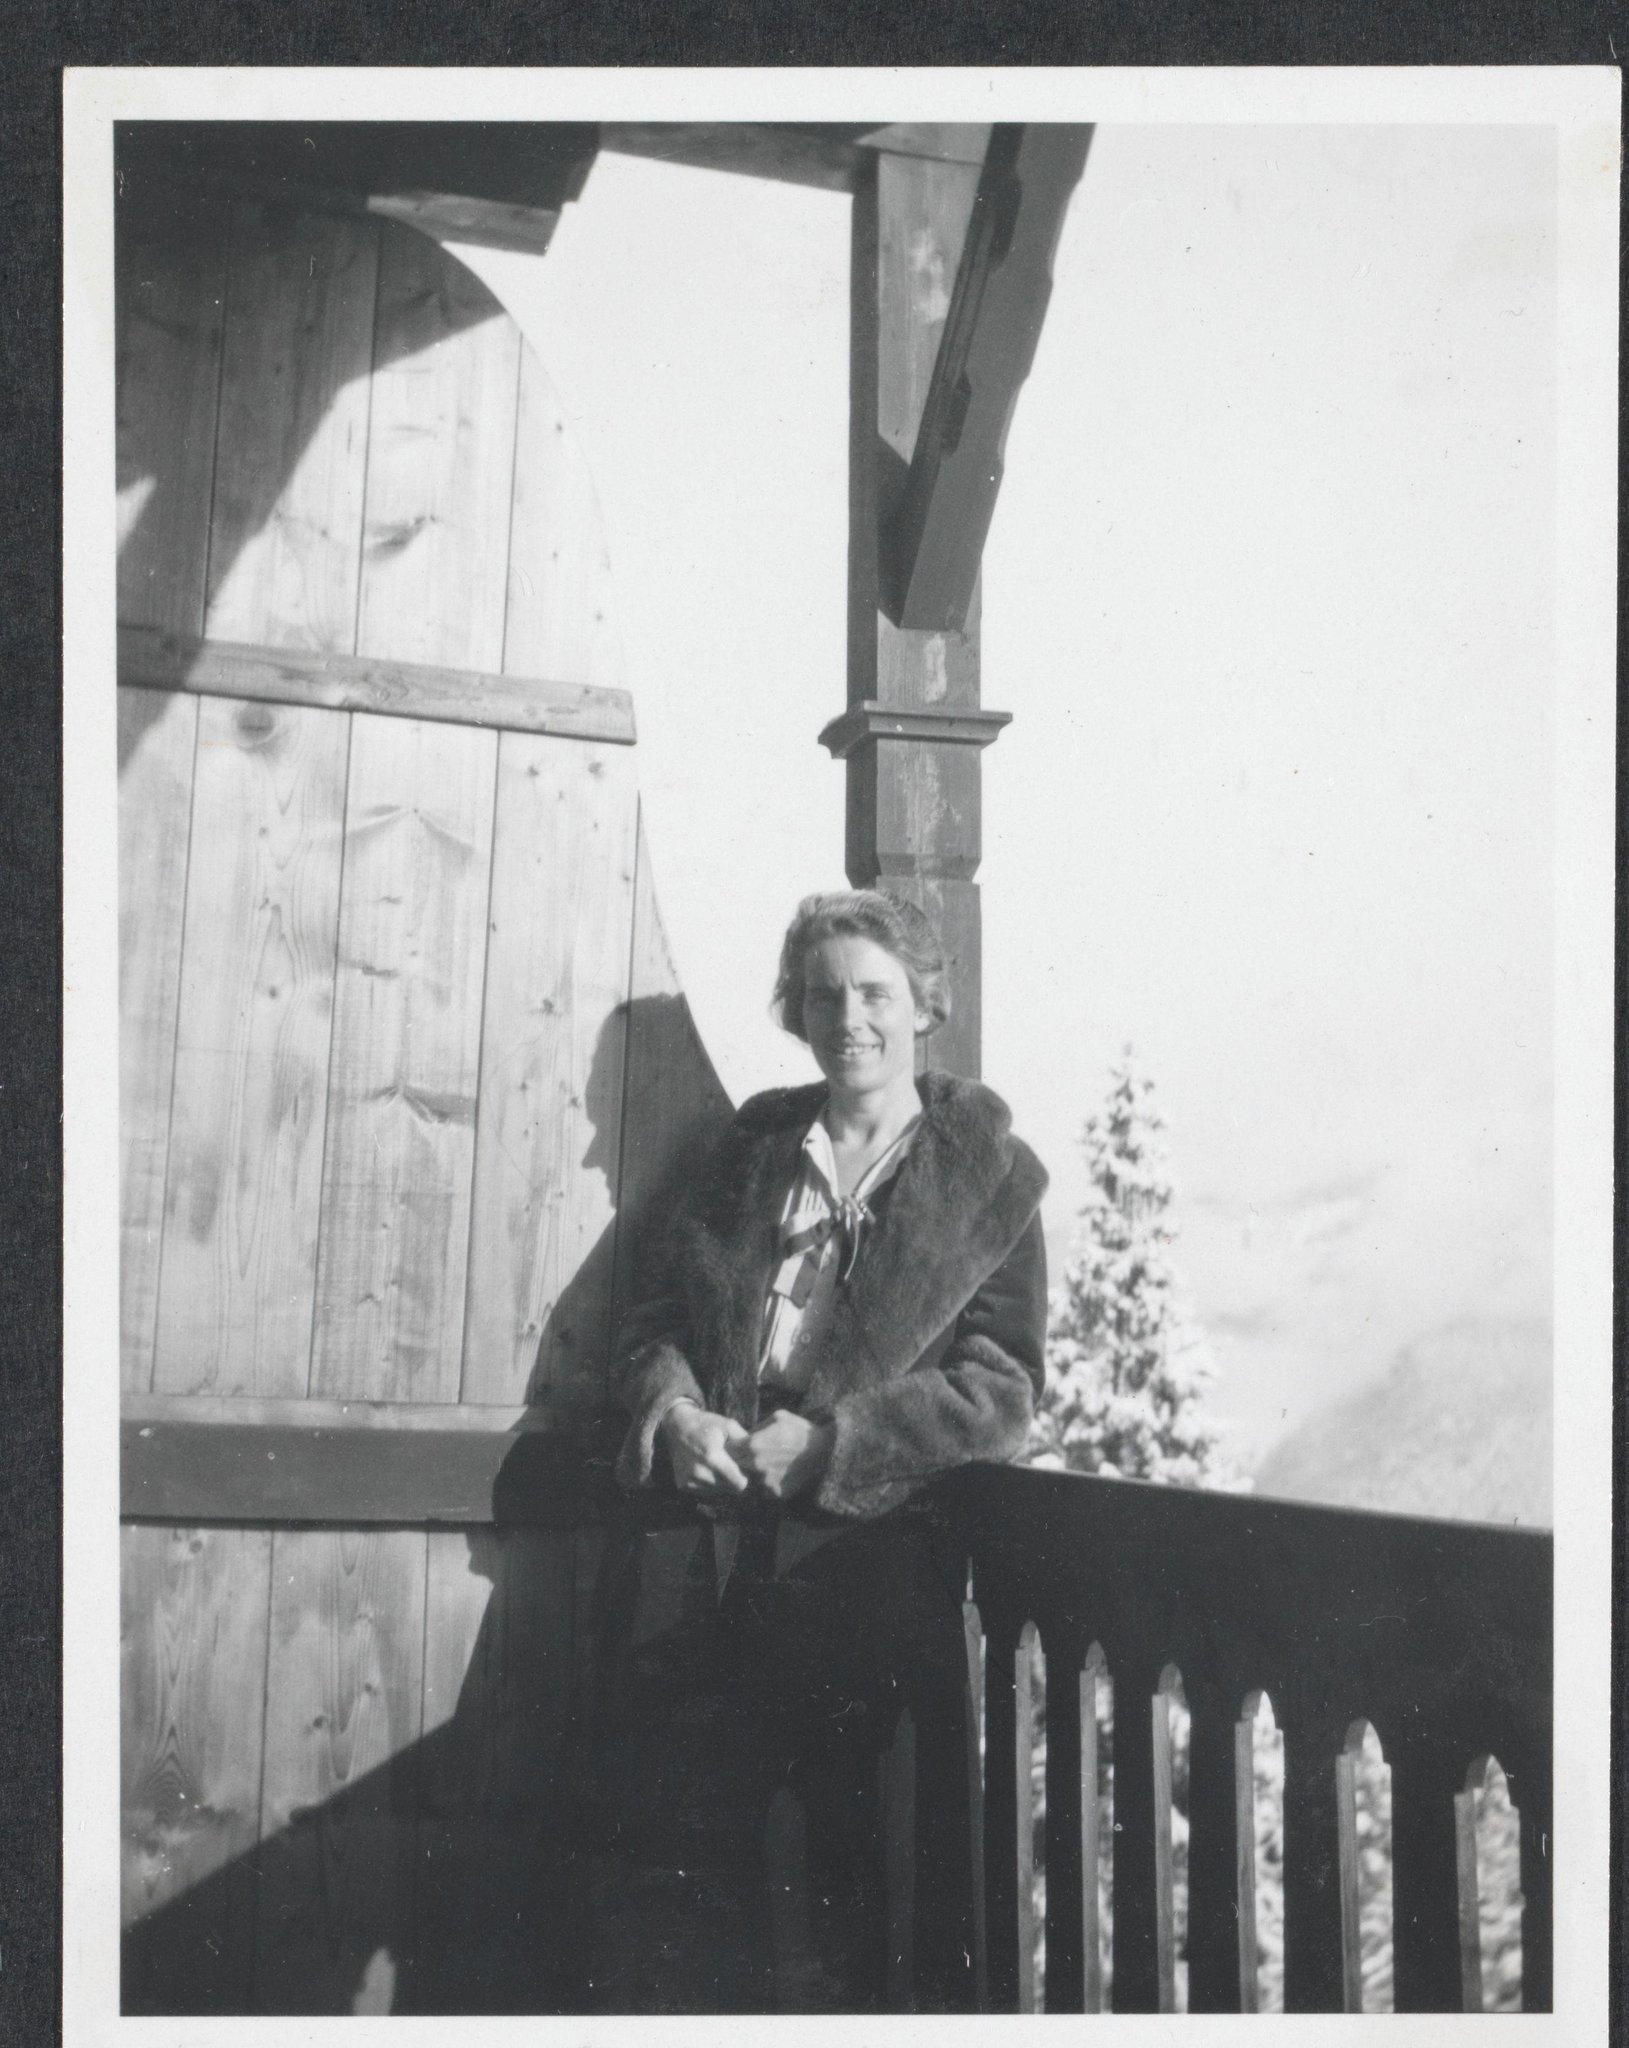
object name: photograph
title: Mevrouw A.H. Crone poserend op een balkon in de bergen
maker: Anonymous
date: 1930-1935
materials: photographic support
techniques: gelatin silver print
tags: amsterdam, voorschoten, ada helena hondius-crone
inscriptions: stamp: ‘De Amateur H977 P.C. Hoofstraat 60’, negative number: ‘neg. 14635 9/12’